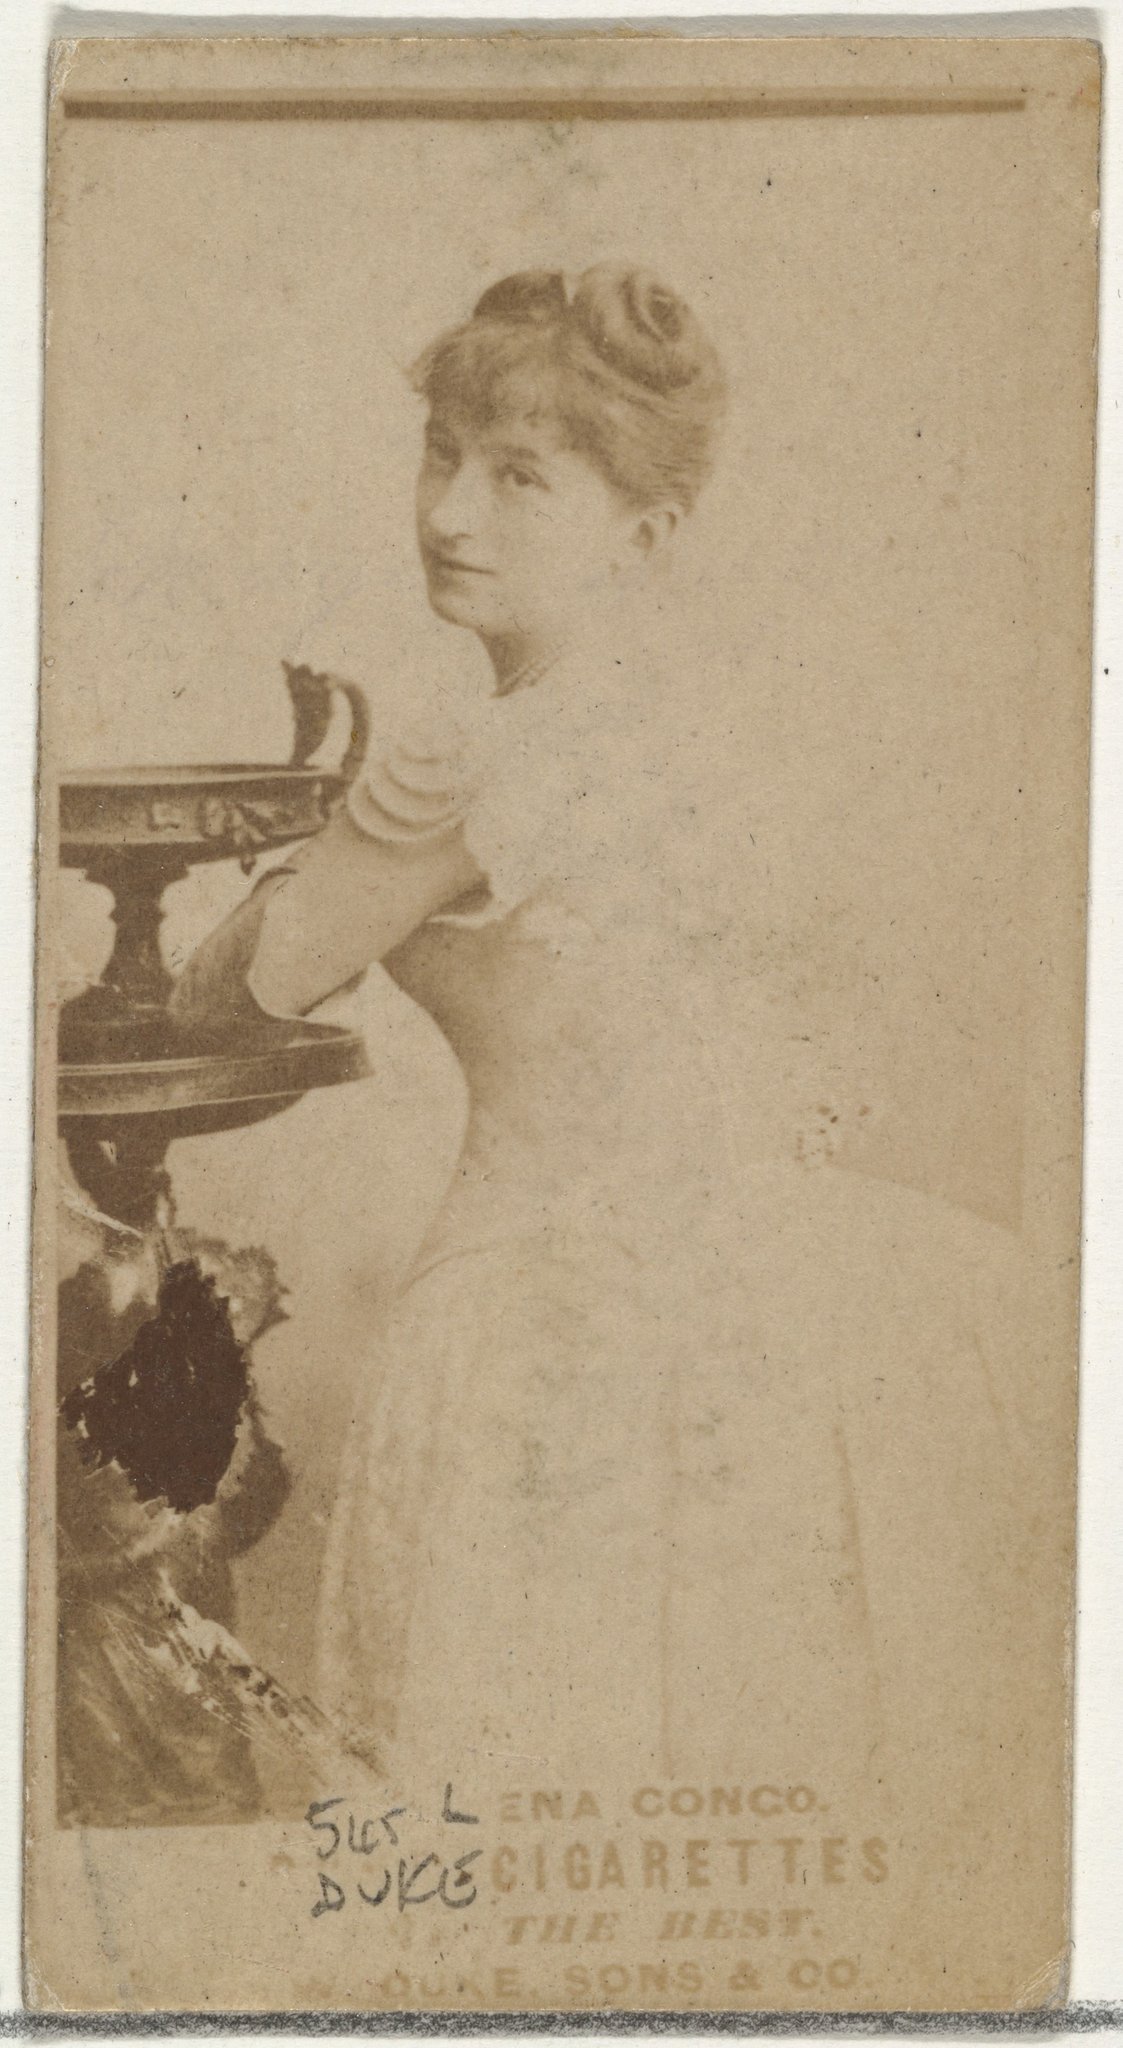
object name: photograph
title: Card Number 545, Lena Congo, from the Actors and Actresses series (N145-3) issued by Duke Sons & Co. to promote Cross Cut Cigarettes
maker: w. duke, sons & co.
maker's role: publisher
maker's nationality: american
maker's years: 1870-1920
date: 1880-1889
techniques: albumen silver print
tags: portraits,women,actresses